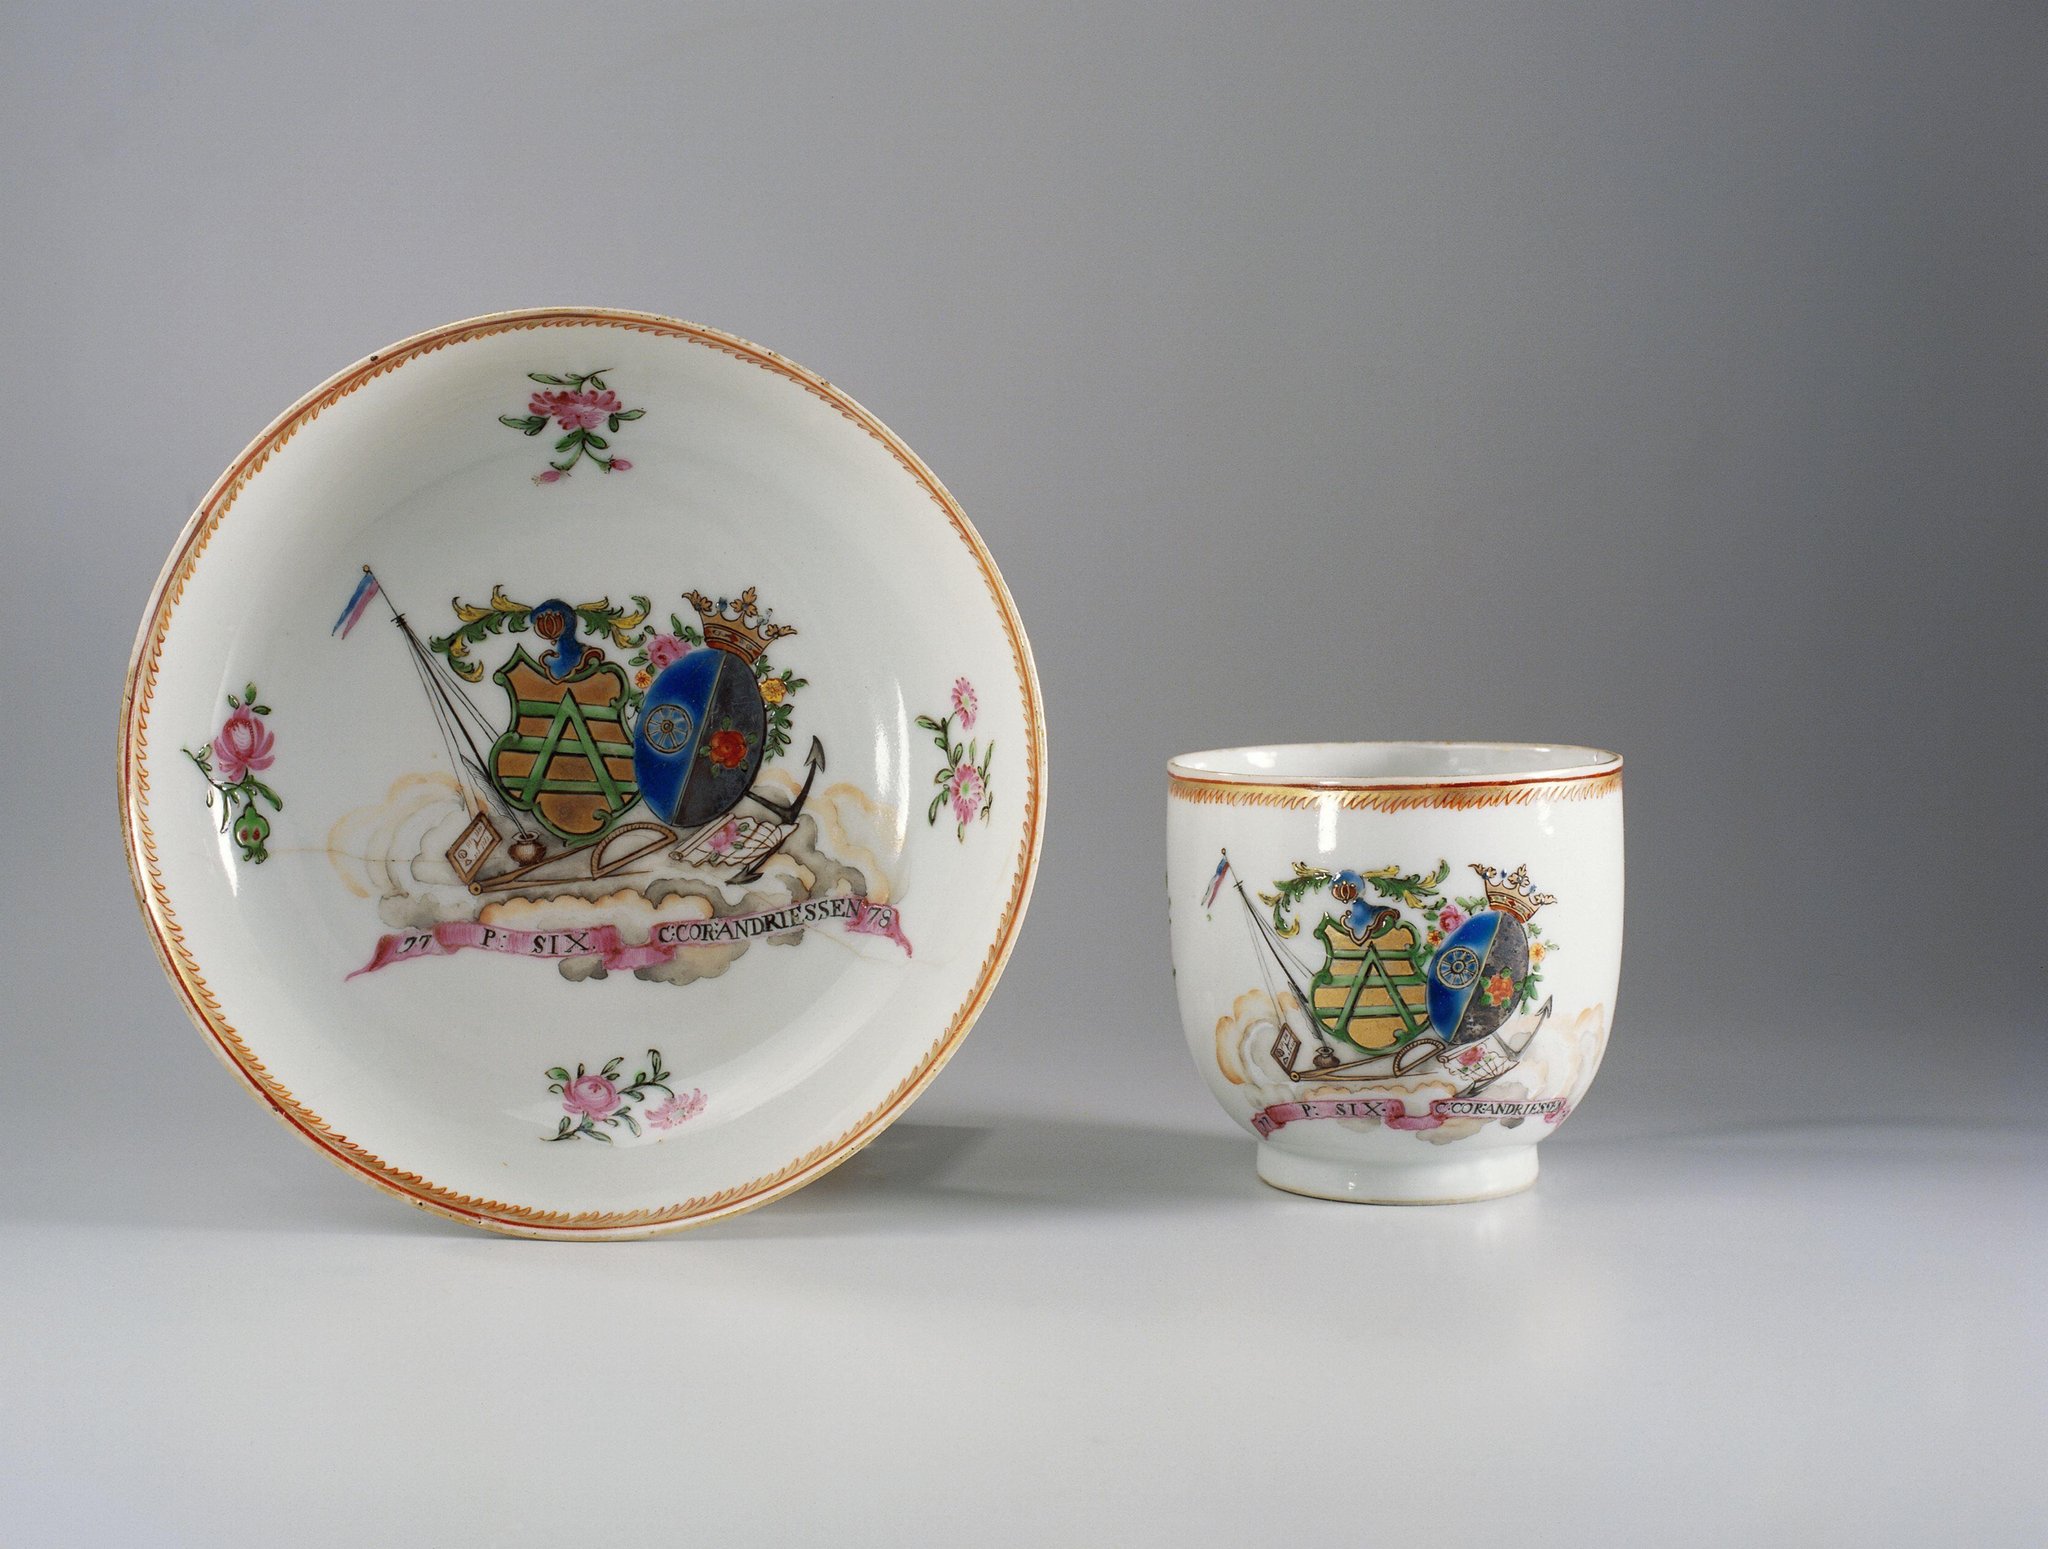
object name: cup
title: Cup with handle with the arms of the Six and Andriessen family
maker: Anonymous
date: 1778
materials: glaze, gold, paint, porcelain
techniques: firing, gilding, turning, vitrification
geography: china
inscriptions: inscription: ‘P:SIX/ C:COR:ANDRIESSEN/ 1778’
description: Oorkop en schotel van porselein, beschilderd op het glazuur in blauw, rood, roze, groen, geel, zwart en goud. Op de wand het alliantiewapen van de families Six en Andriessen. Aan de linkerkant het wapen van Six in groen en goud. Daarboven een helm met ranken, maar geen helmteken. Het wapen van Andriessen aan de rechterkant is opgedeeld in twee velden; een blauwe achtergrond met een wiel en een zwarte achtergrond met een roos. Het wapen is omgeven door guirlandes en boven het wapen is een kroon geschilderd. De twee wapens staan op wolken omgeven door een vlaggenmast met de Nederlandse vlag, een anker, meetinstrumenten, een kaart en schrijfgerei. Onder het wapen een banderol met het opschrift 'P:SIX/ C:COR:ANDRIESSEN/ 1778'. Op de wand vier bloemtakken en op de rand een decoratieve band. Wapenporselein met emailkleuren.